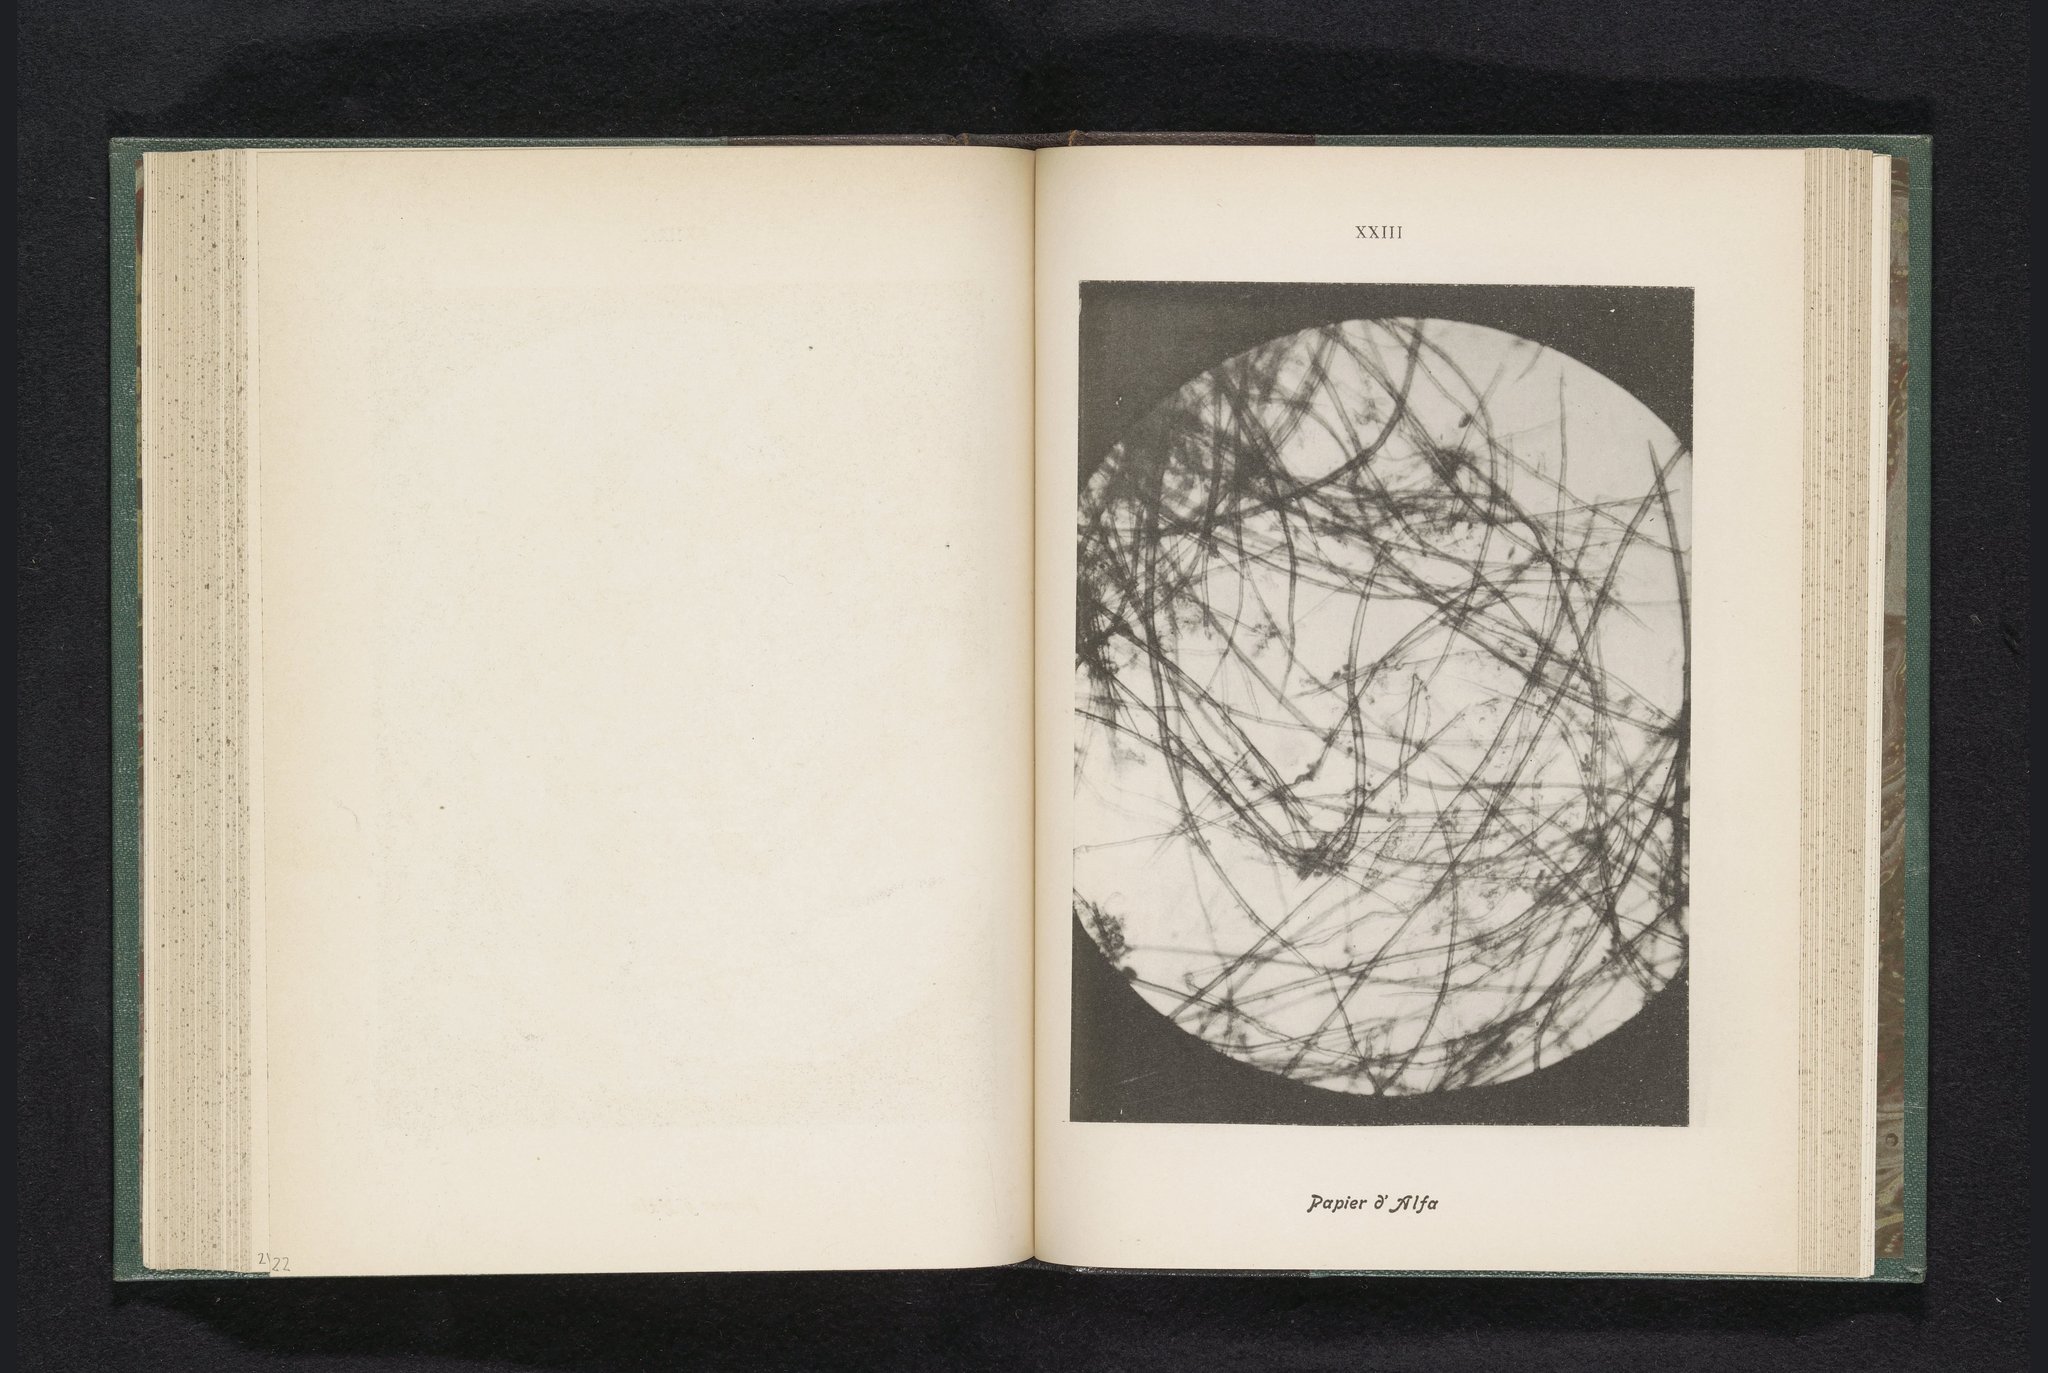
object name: page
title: Papier d'alfa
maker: Anonymous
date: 1890-1900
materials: paper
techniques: photograph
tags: cereal, grain, corn (grass with grains, grown for food, e.g.: wheat, rice, rye, oats, maize, buckwheat, millet)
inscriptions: number: ‘XXIII’